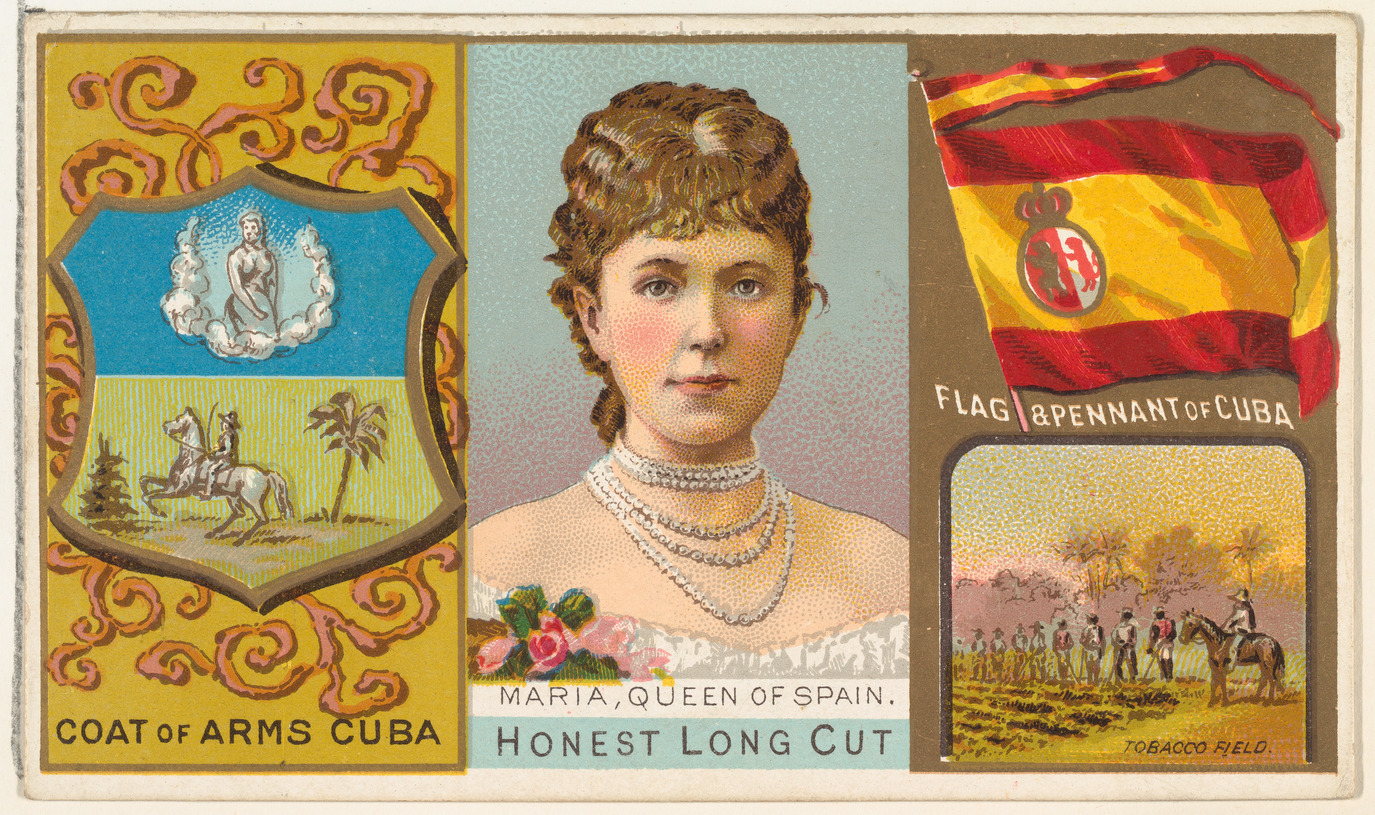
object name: print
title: Maria, Queen of Spain, from the Rulers, Flags, and Coats of Arms series (N126-1) issued by W. Duke, Sons & Co.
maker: w. duke, sons & co.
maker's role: publisher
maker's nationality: american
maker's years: 1870-1920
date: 1888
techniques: color lithograph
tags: queens,portraits,coat of arms,flags